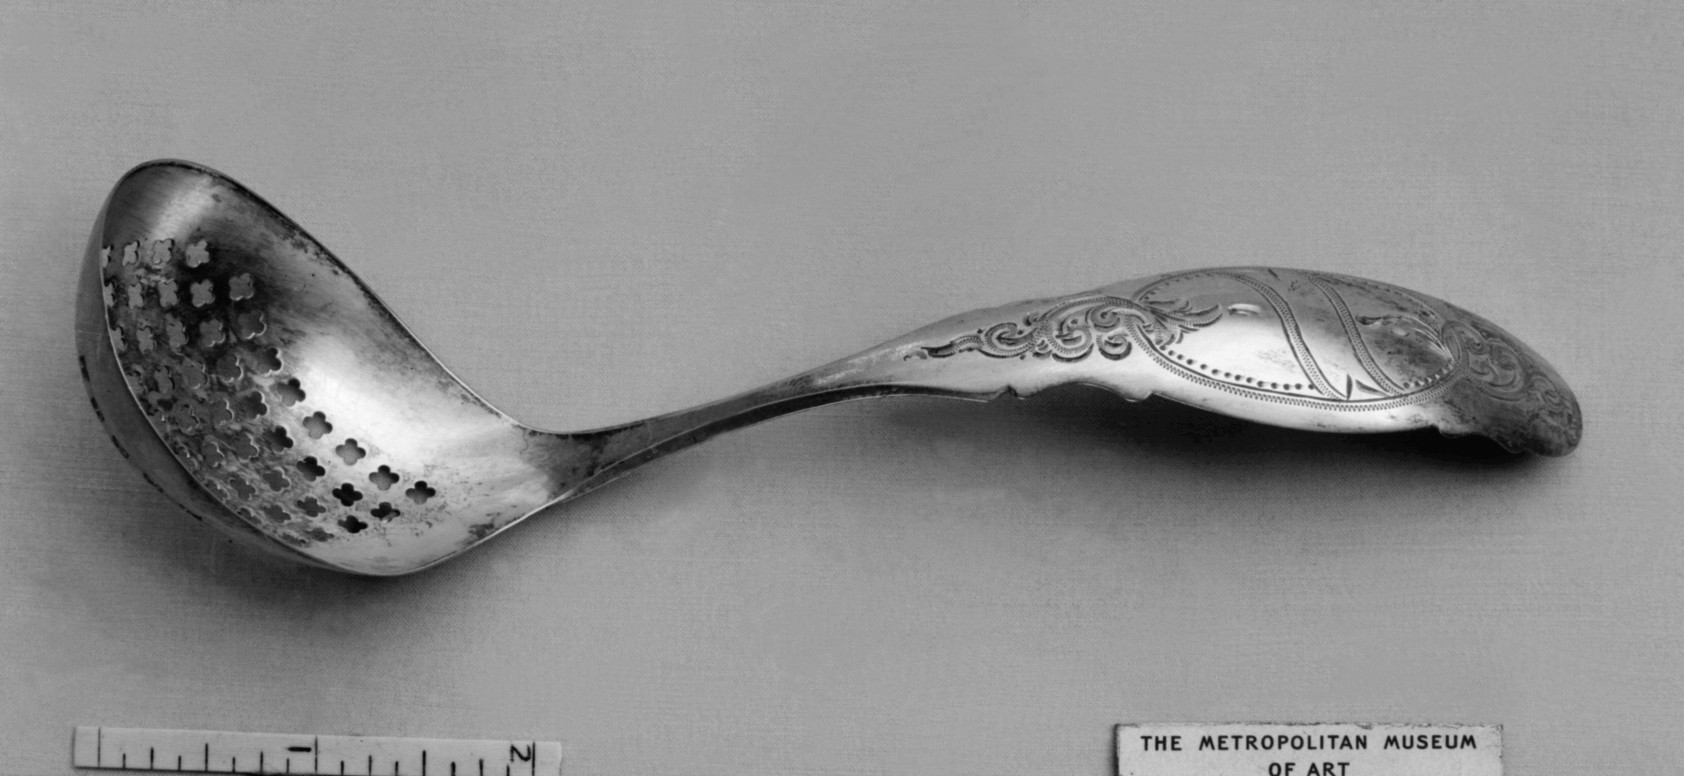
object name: sugar sifter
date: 1801-1900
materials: silver